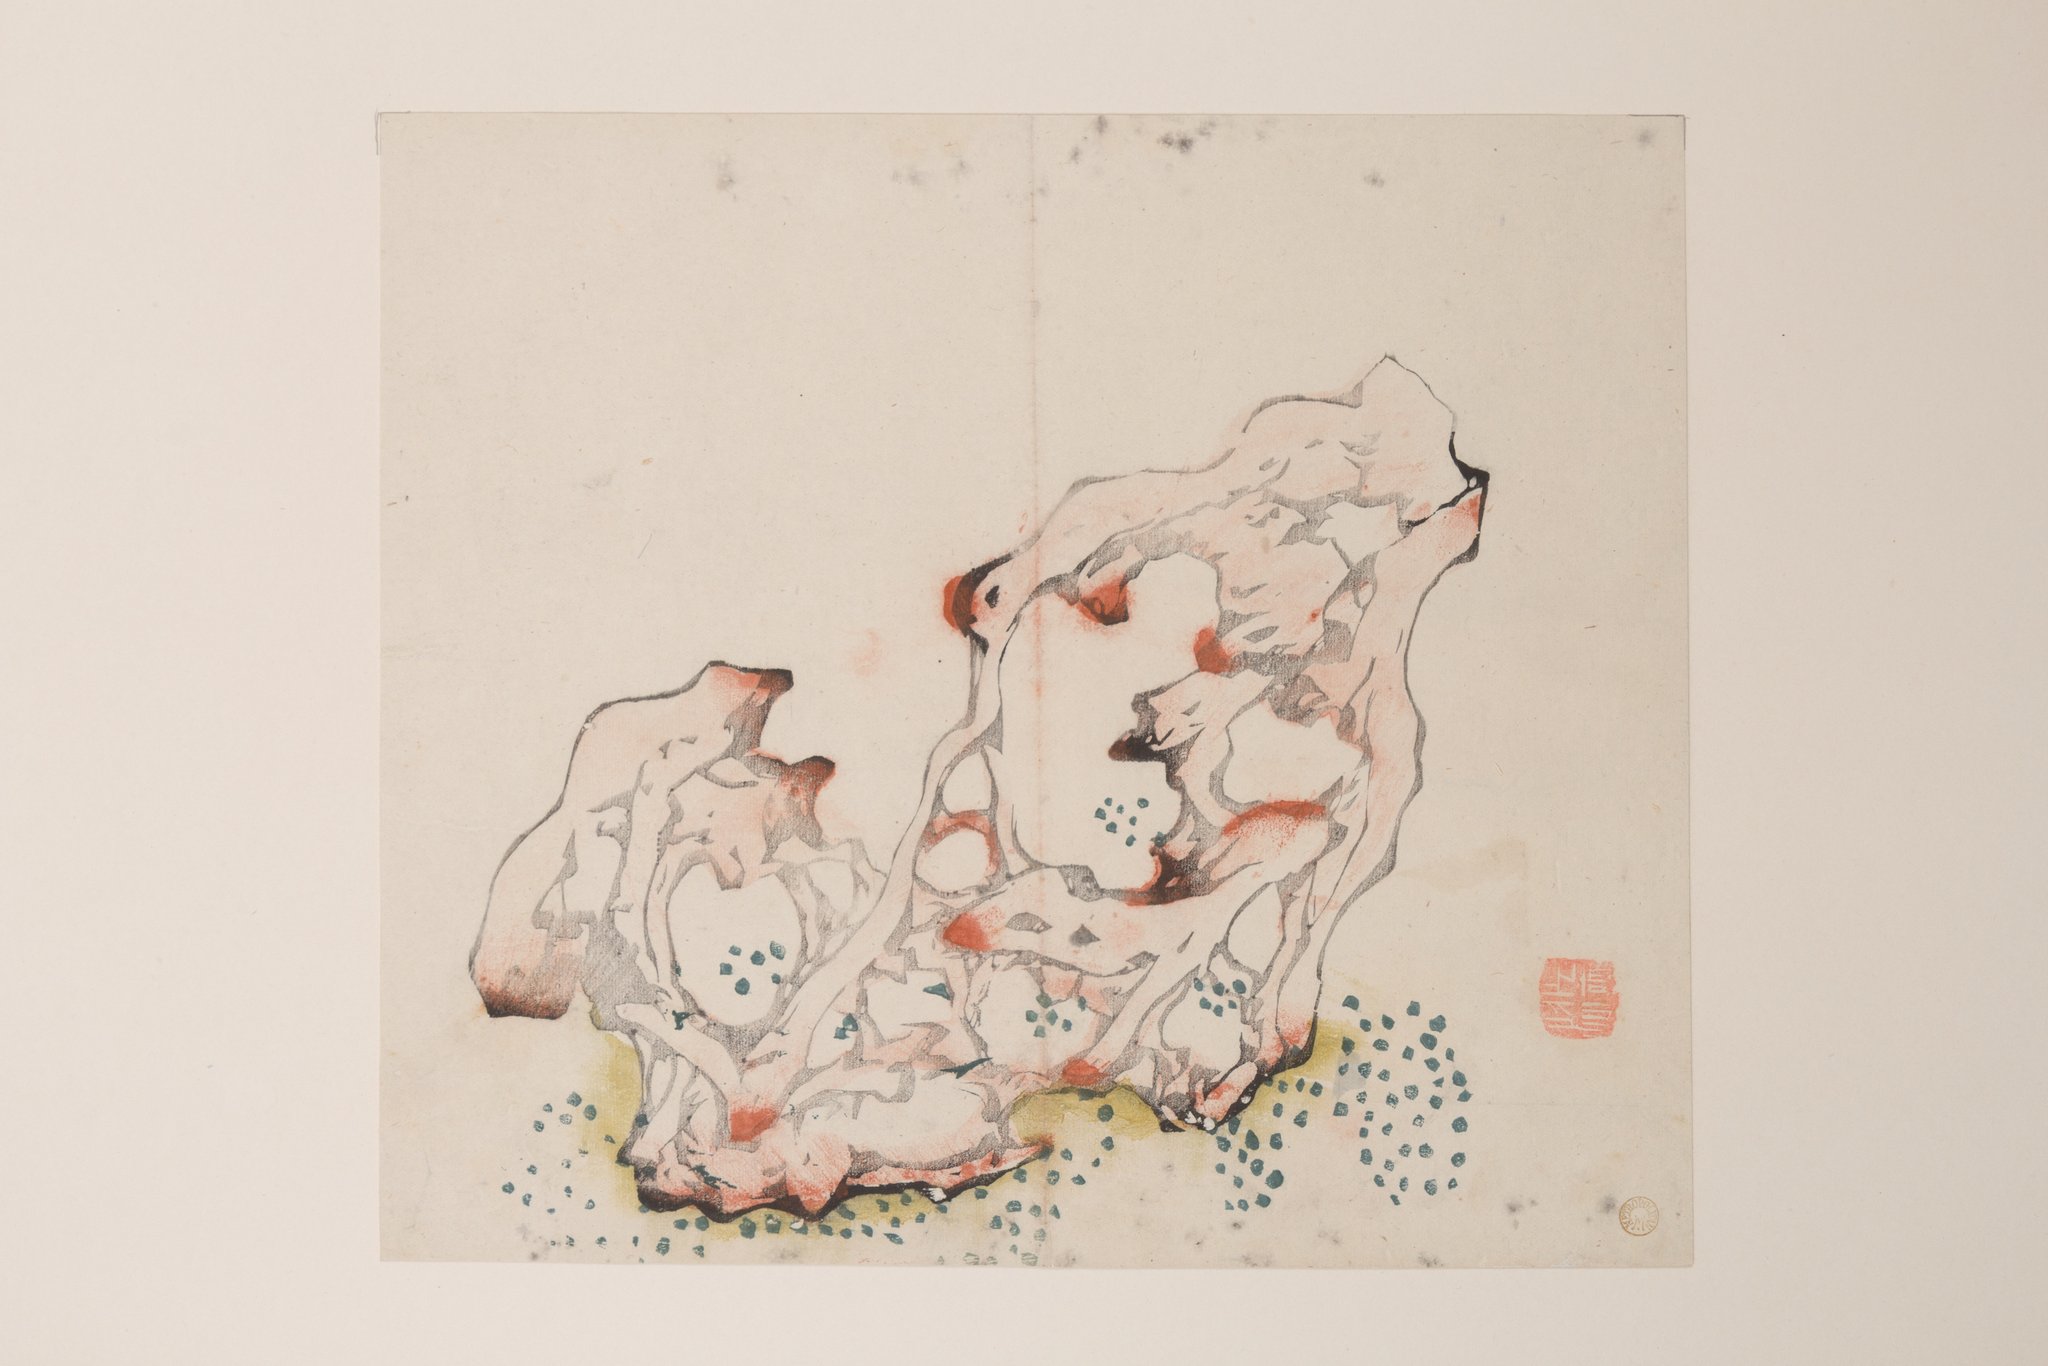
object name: print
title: Page from the Ten Bamboo Studio Manual of Painting and Calligraphy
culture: chinese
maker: hu zhengyan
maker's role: artist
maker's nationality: chinese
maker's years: 1584-1634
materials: ink, paper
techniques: printing